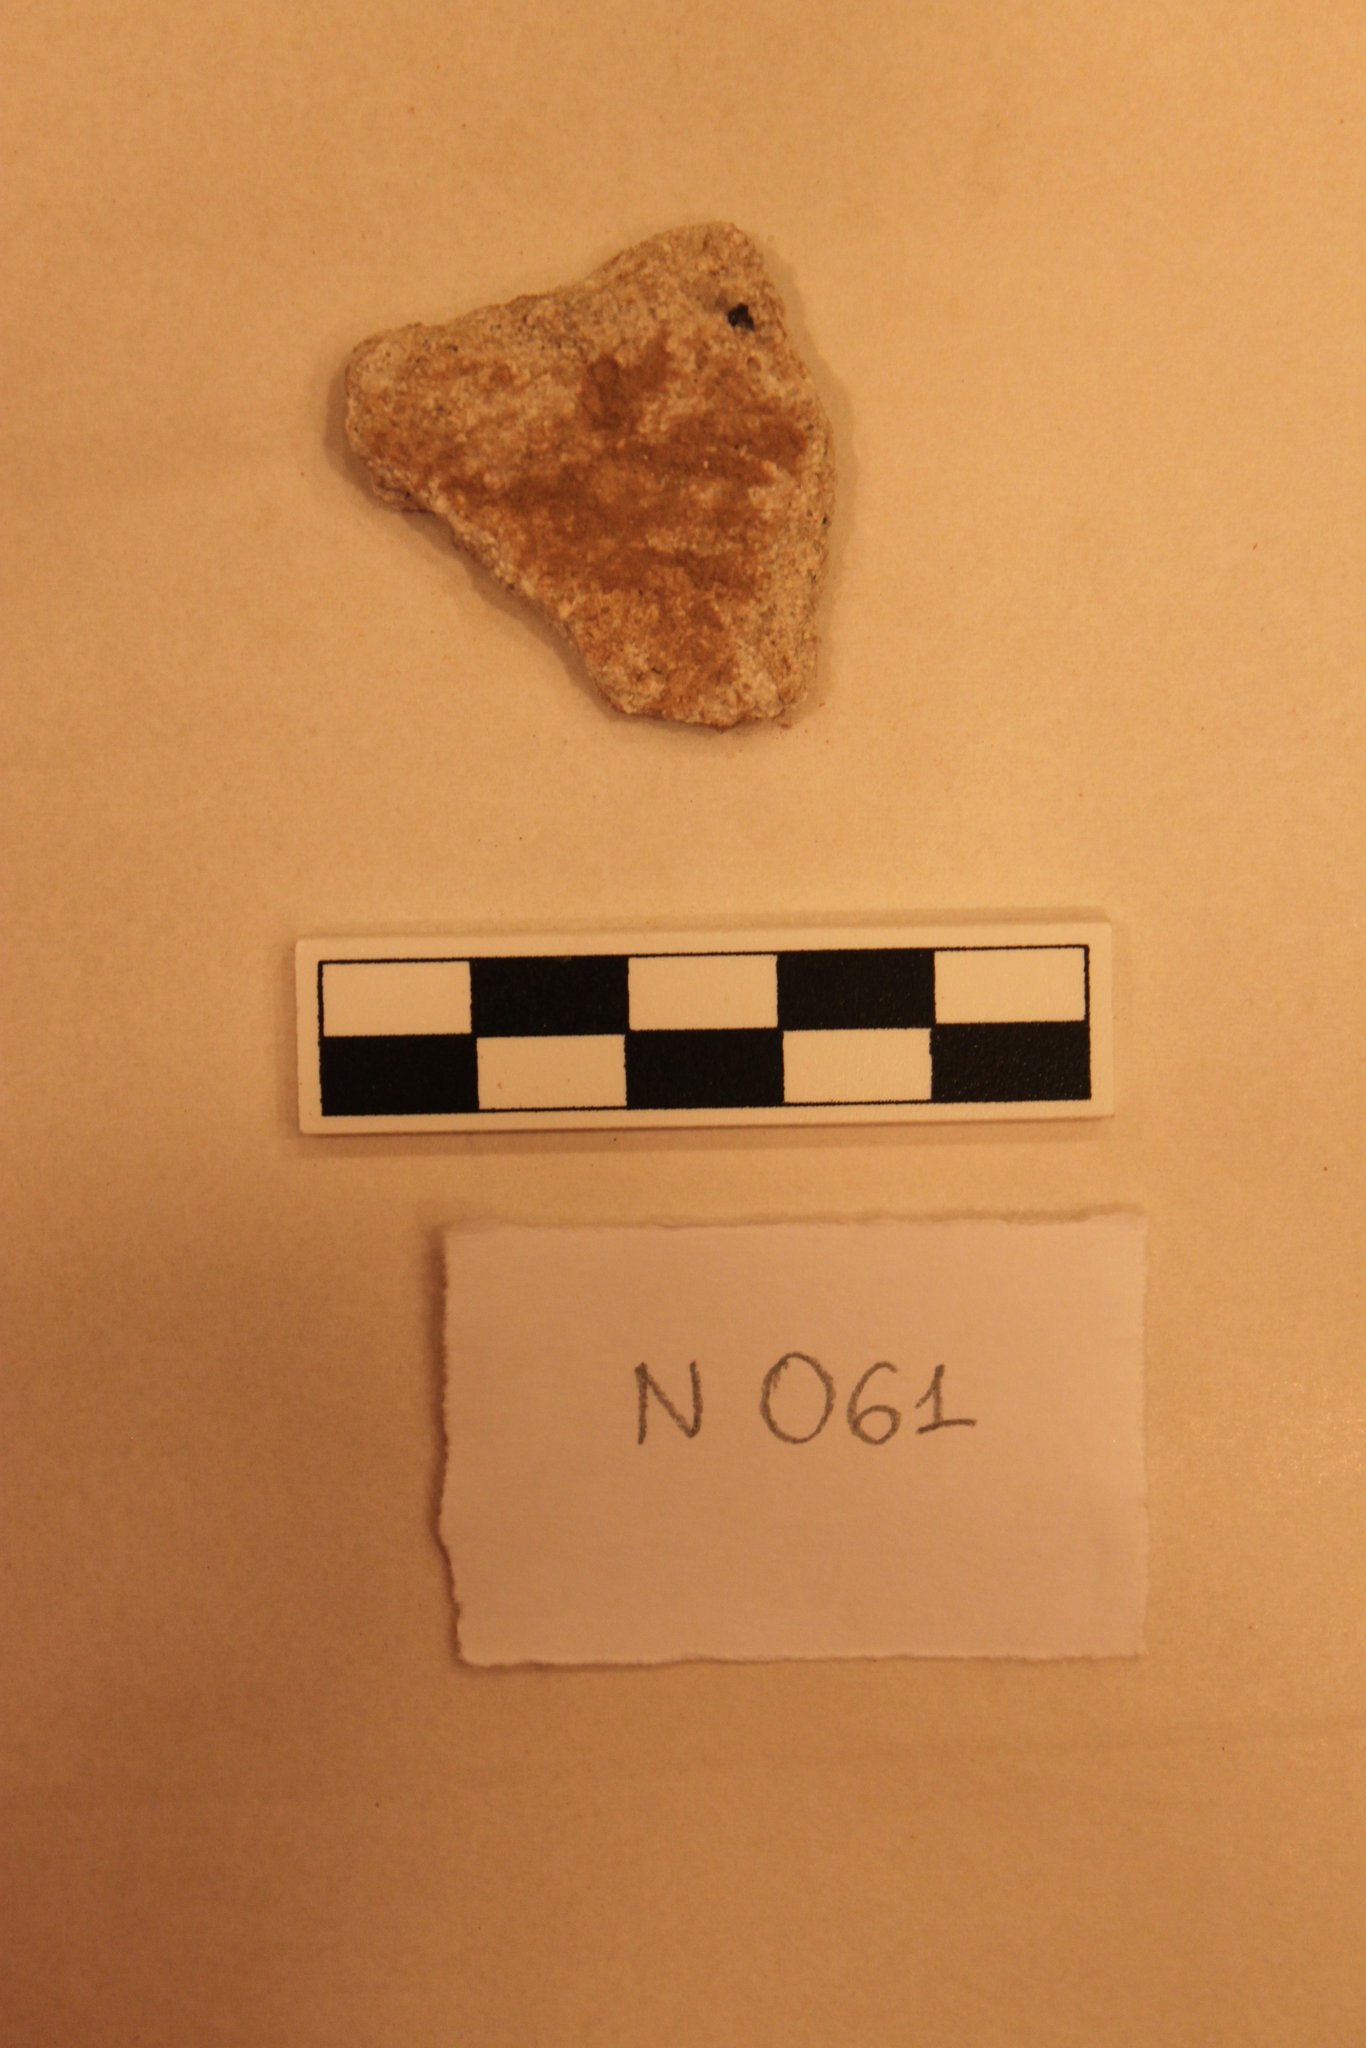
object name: fragment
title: Stucco Fragment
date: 701-1200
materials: plaster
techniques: carving, painting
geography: iran